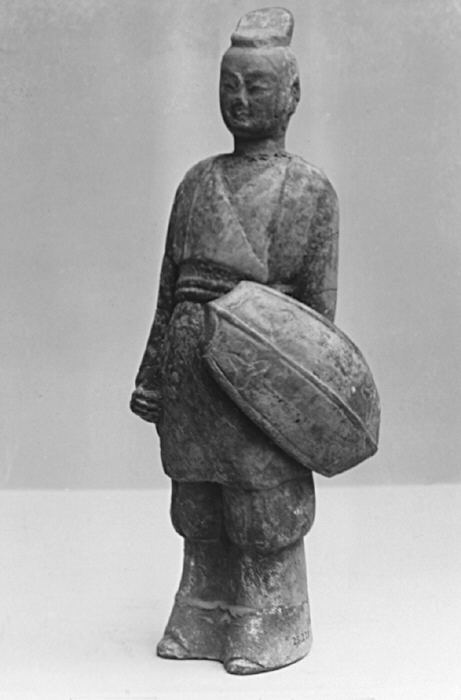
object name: figure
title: Warrior with Shield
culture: chinese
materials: earthenware, pigment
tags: soldiers,shields,men